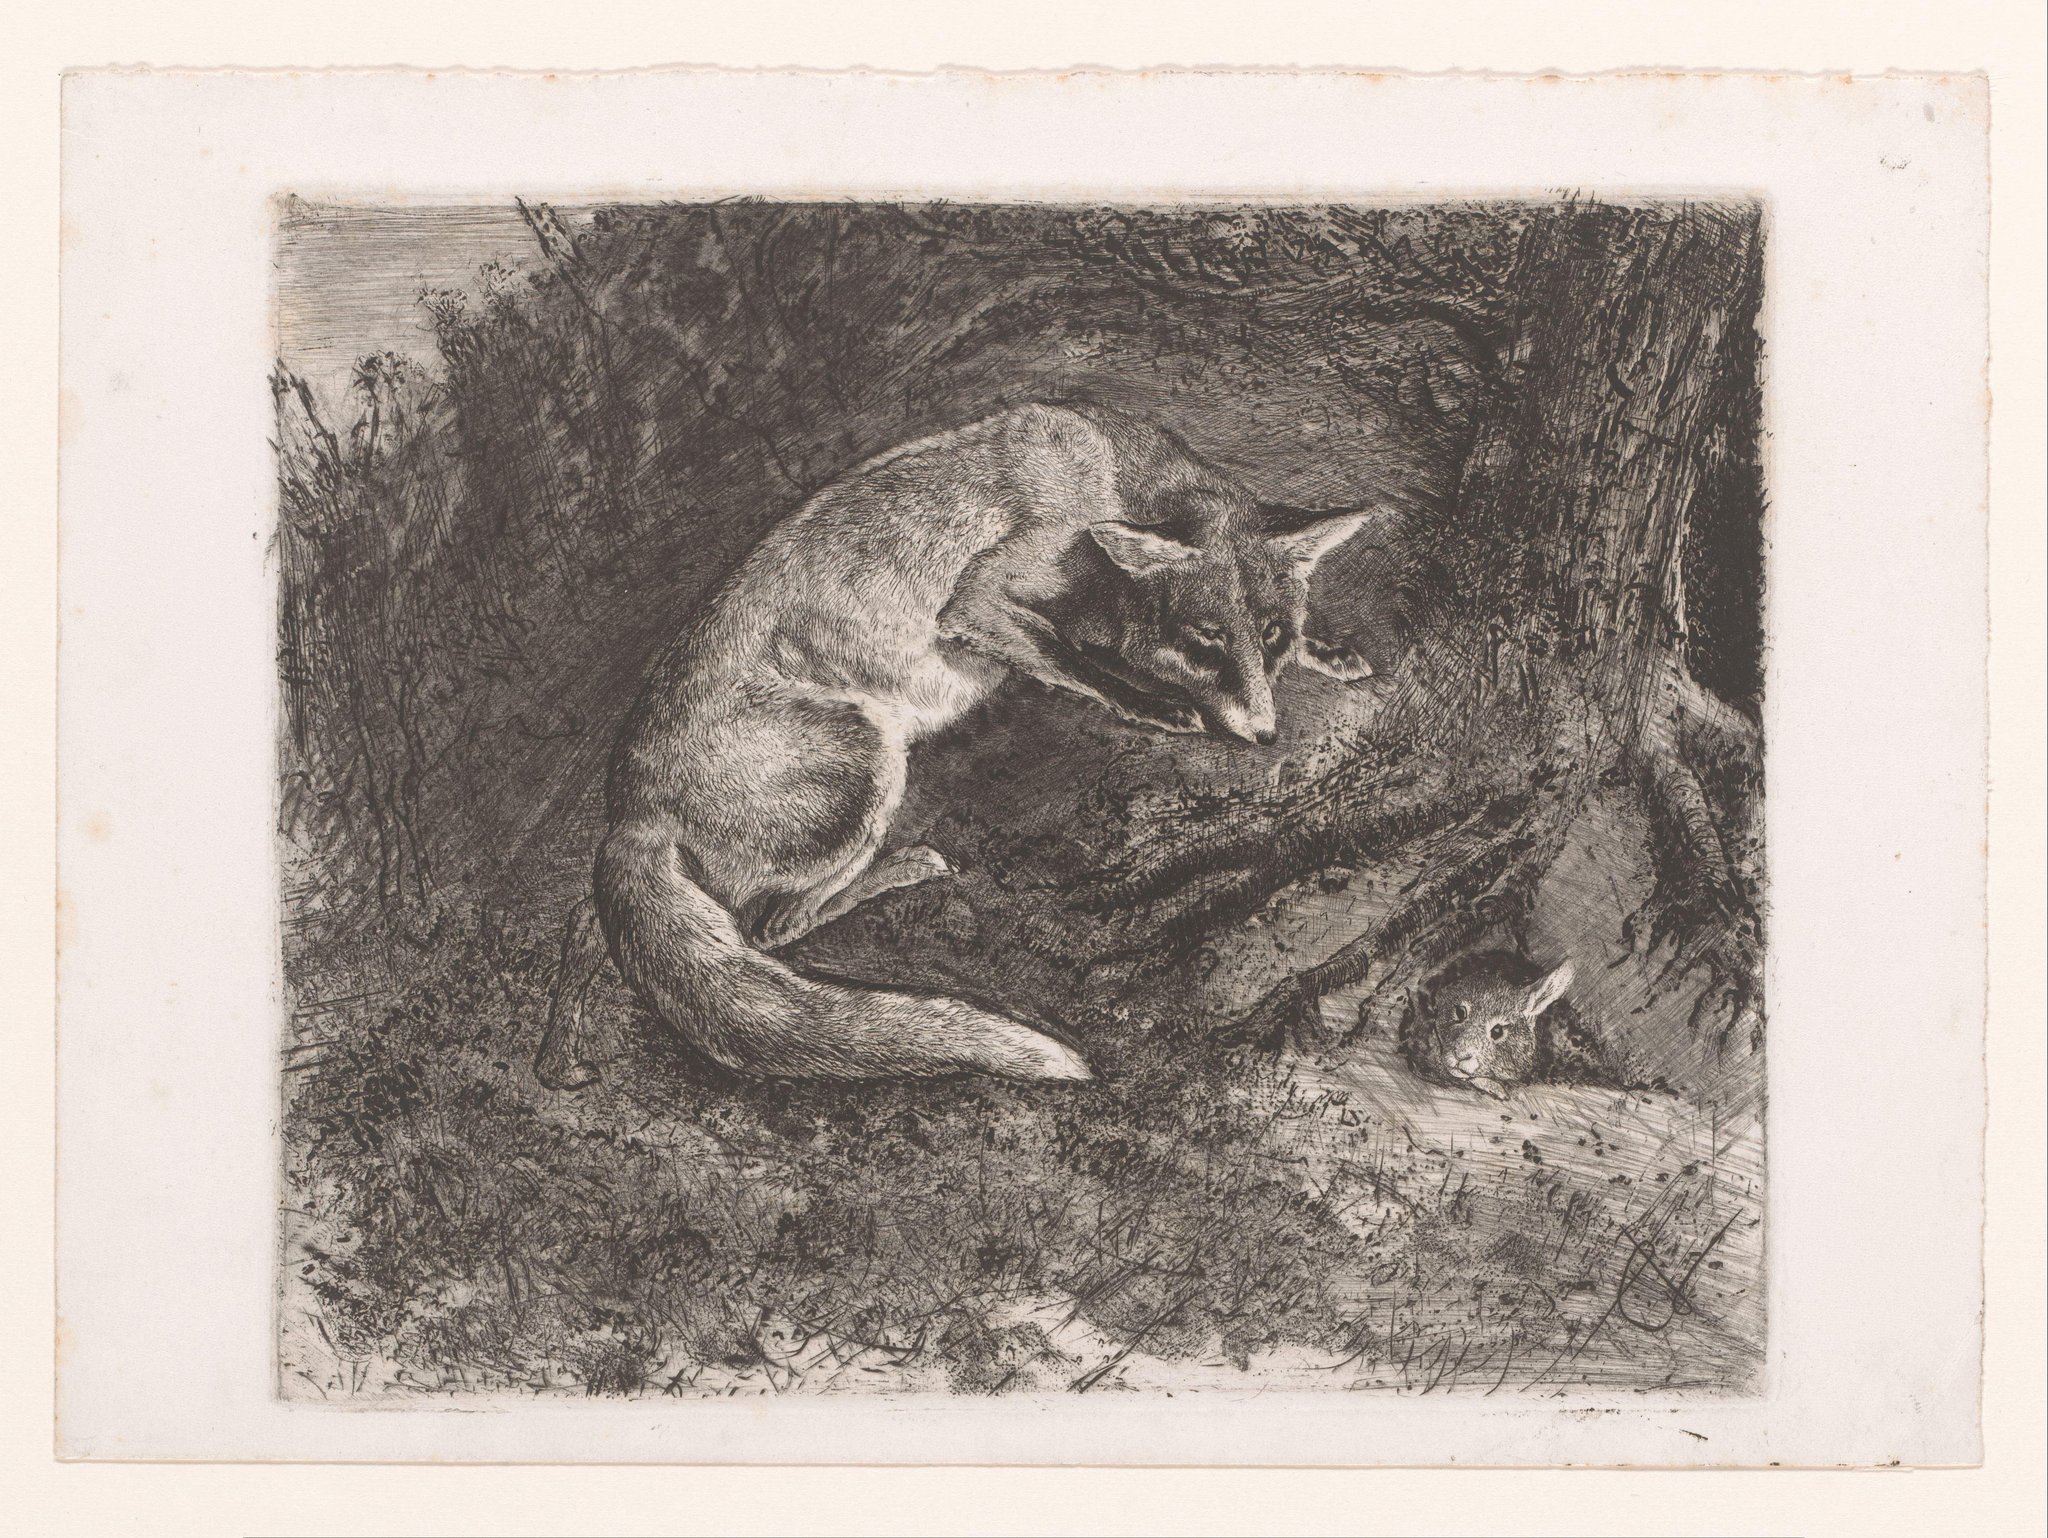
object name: print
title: Vos jagend op een konijn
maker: charles verlat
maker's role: painter, print maker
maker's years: 1824-1890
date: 1834-1890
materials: paper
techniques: drypoint, etching, intaglio, retroussage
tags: beasts of prey, predatory animals: fox (+ animal(s) in pursuit), rodents: rabbit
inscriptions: collector's mark: Lugt 2228